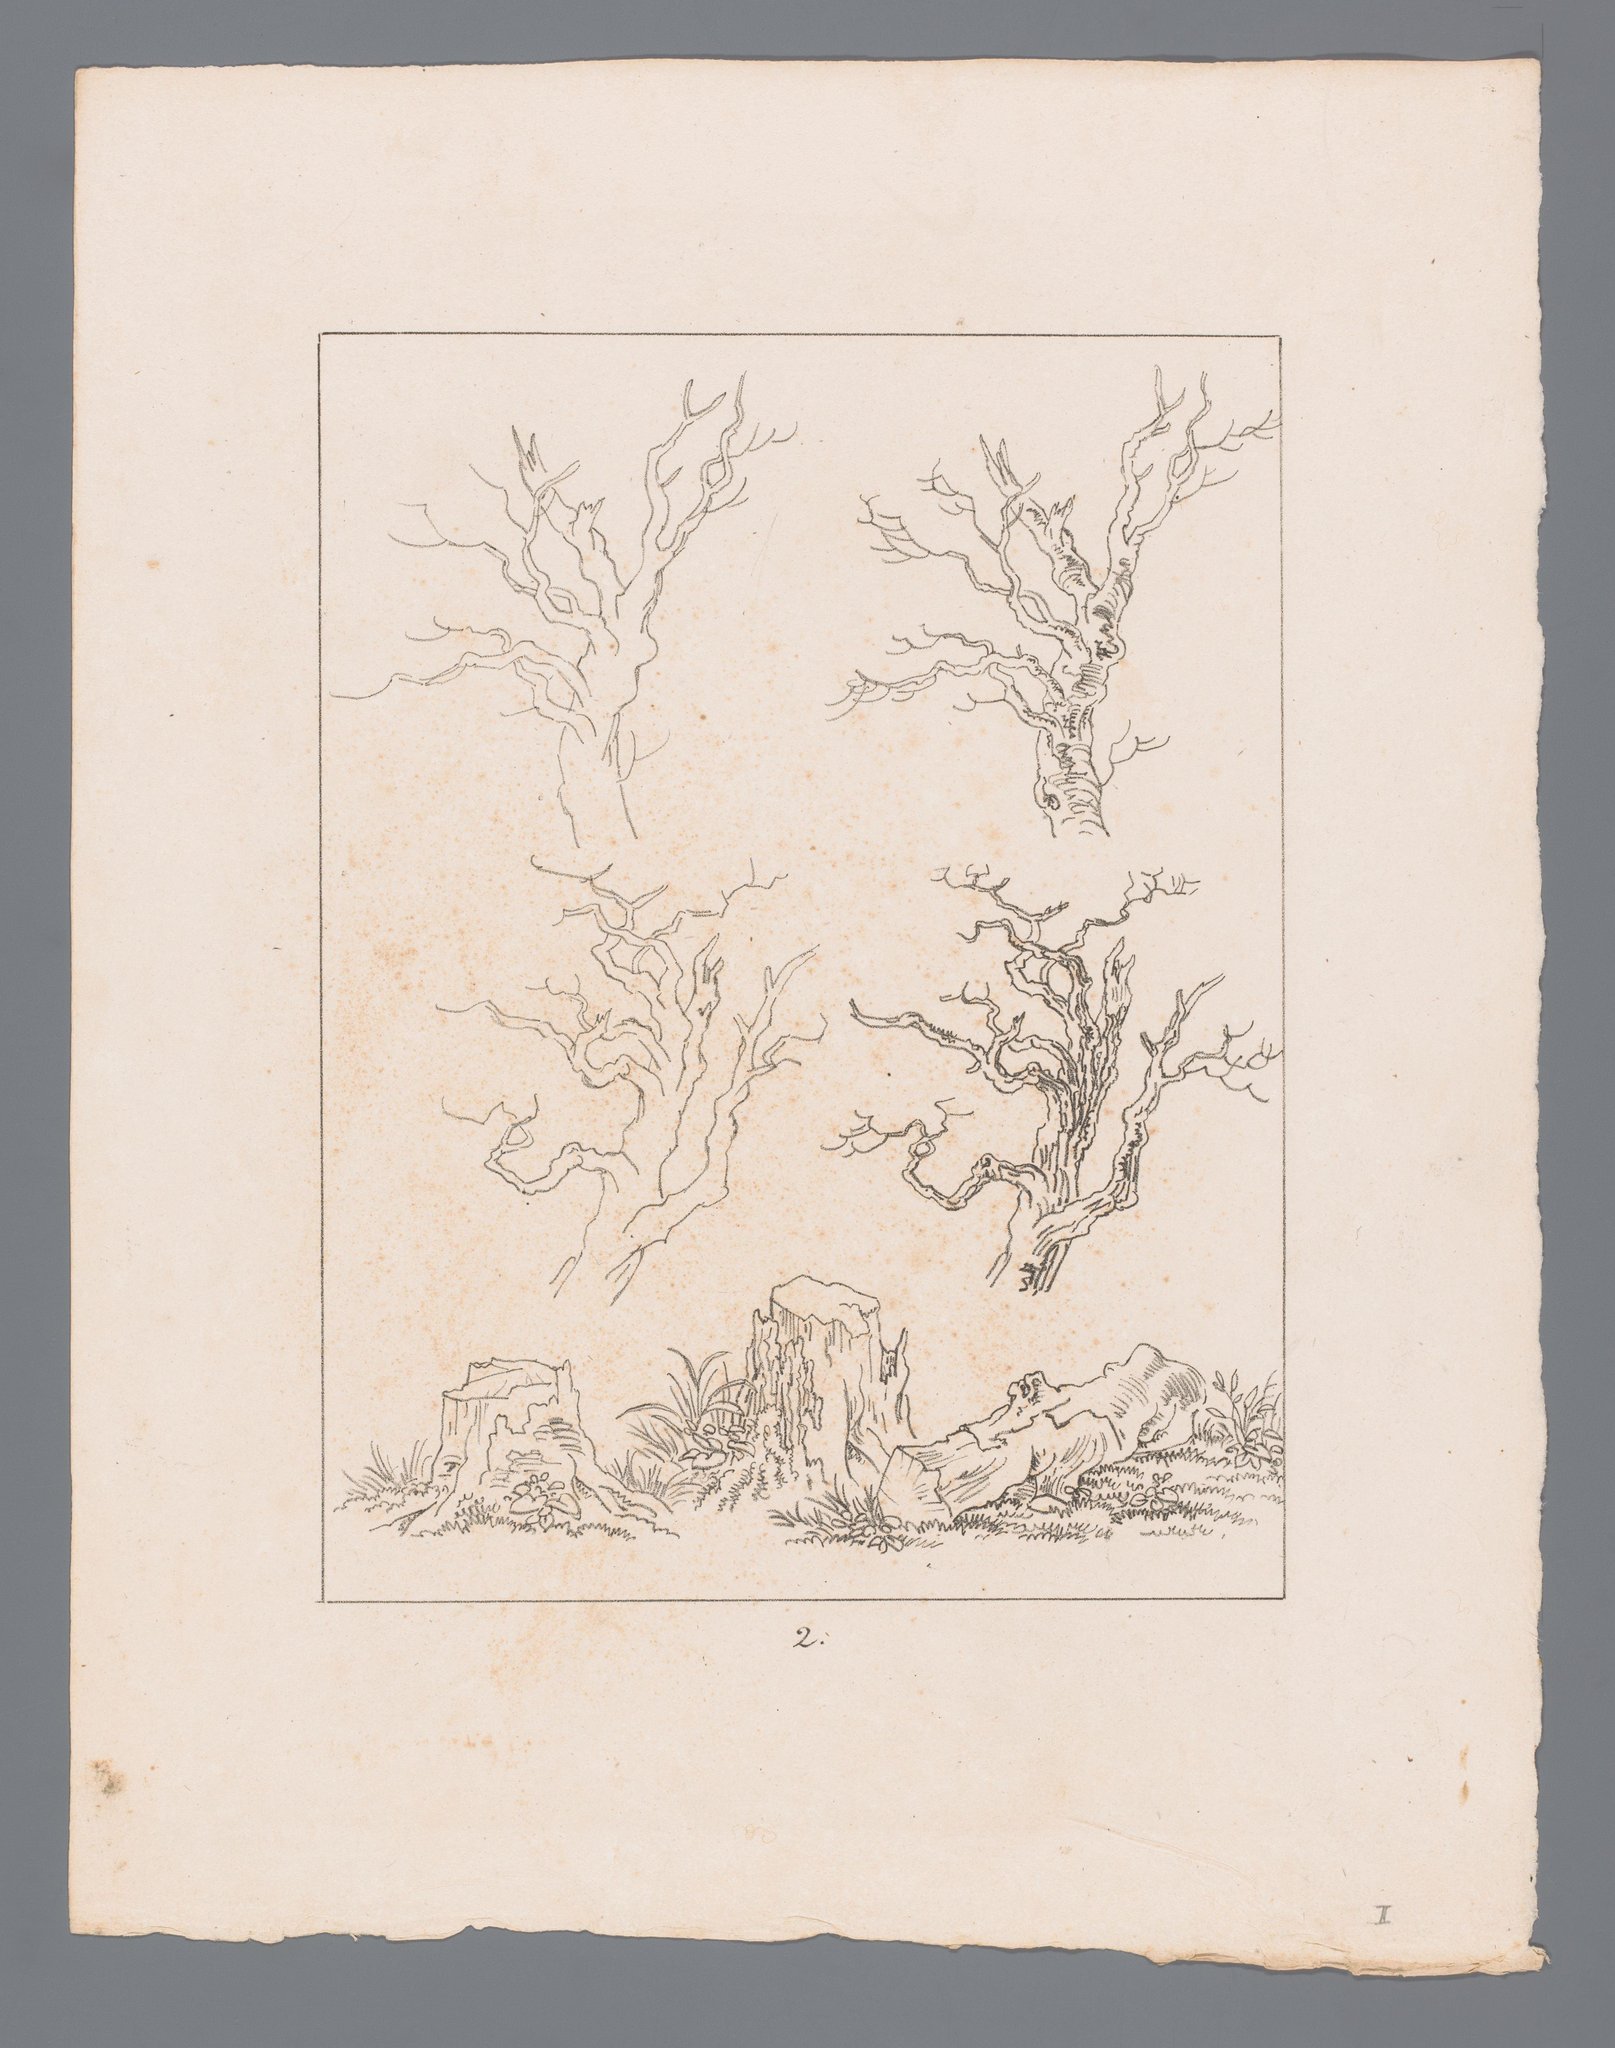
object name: print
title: Voorbeelden voor de landschapstekenaar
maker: max josef wagenbauer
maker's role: print maker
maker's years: 1774-1829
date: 1823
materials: paper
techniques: lithograph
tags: trees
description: Onderdeel van een tweedelige serie waarvan het tweede deel bestaat uit een titelprent en twaalf voorstellingen van takken, bladeren, bomen en landschappen.